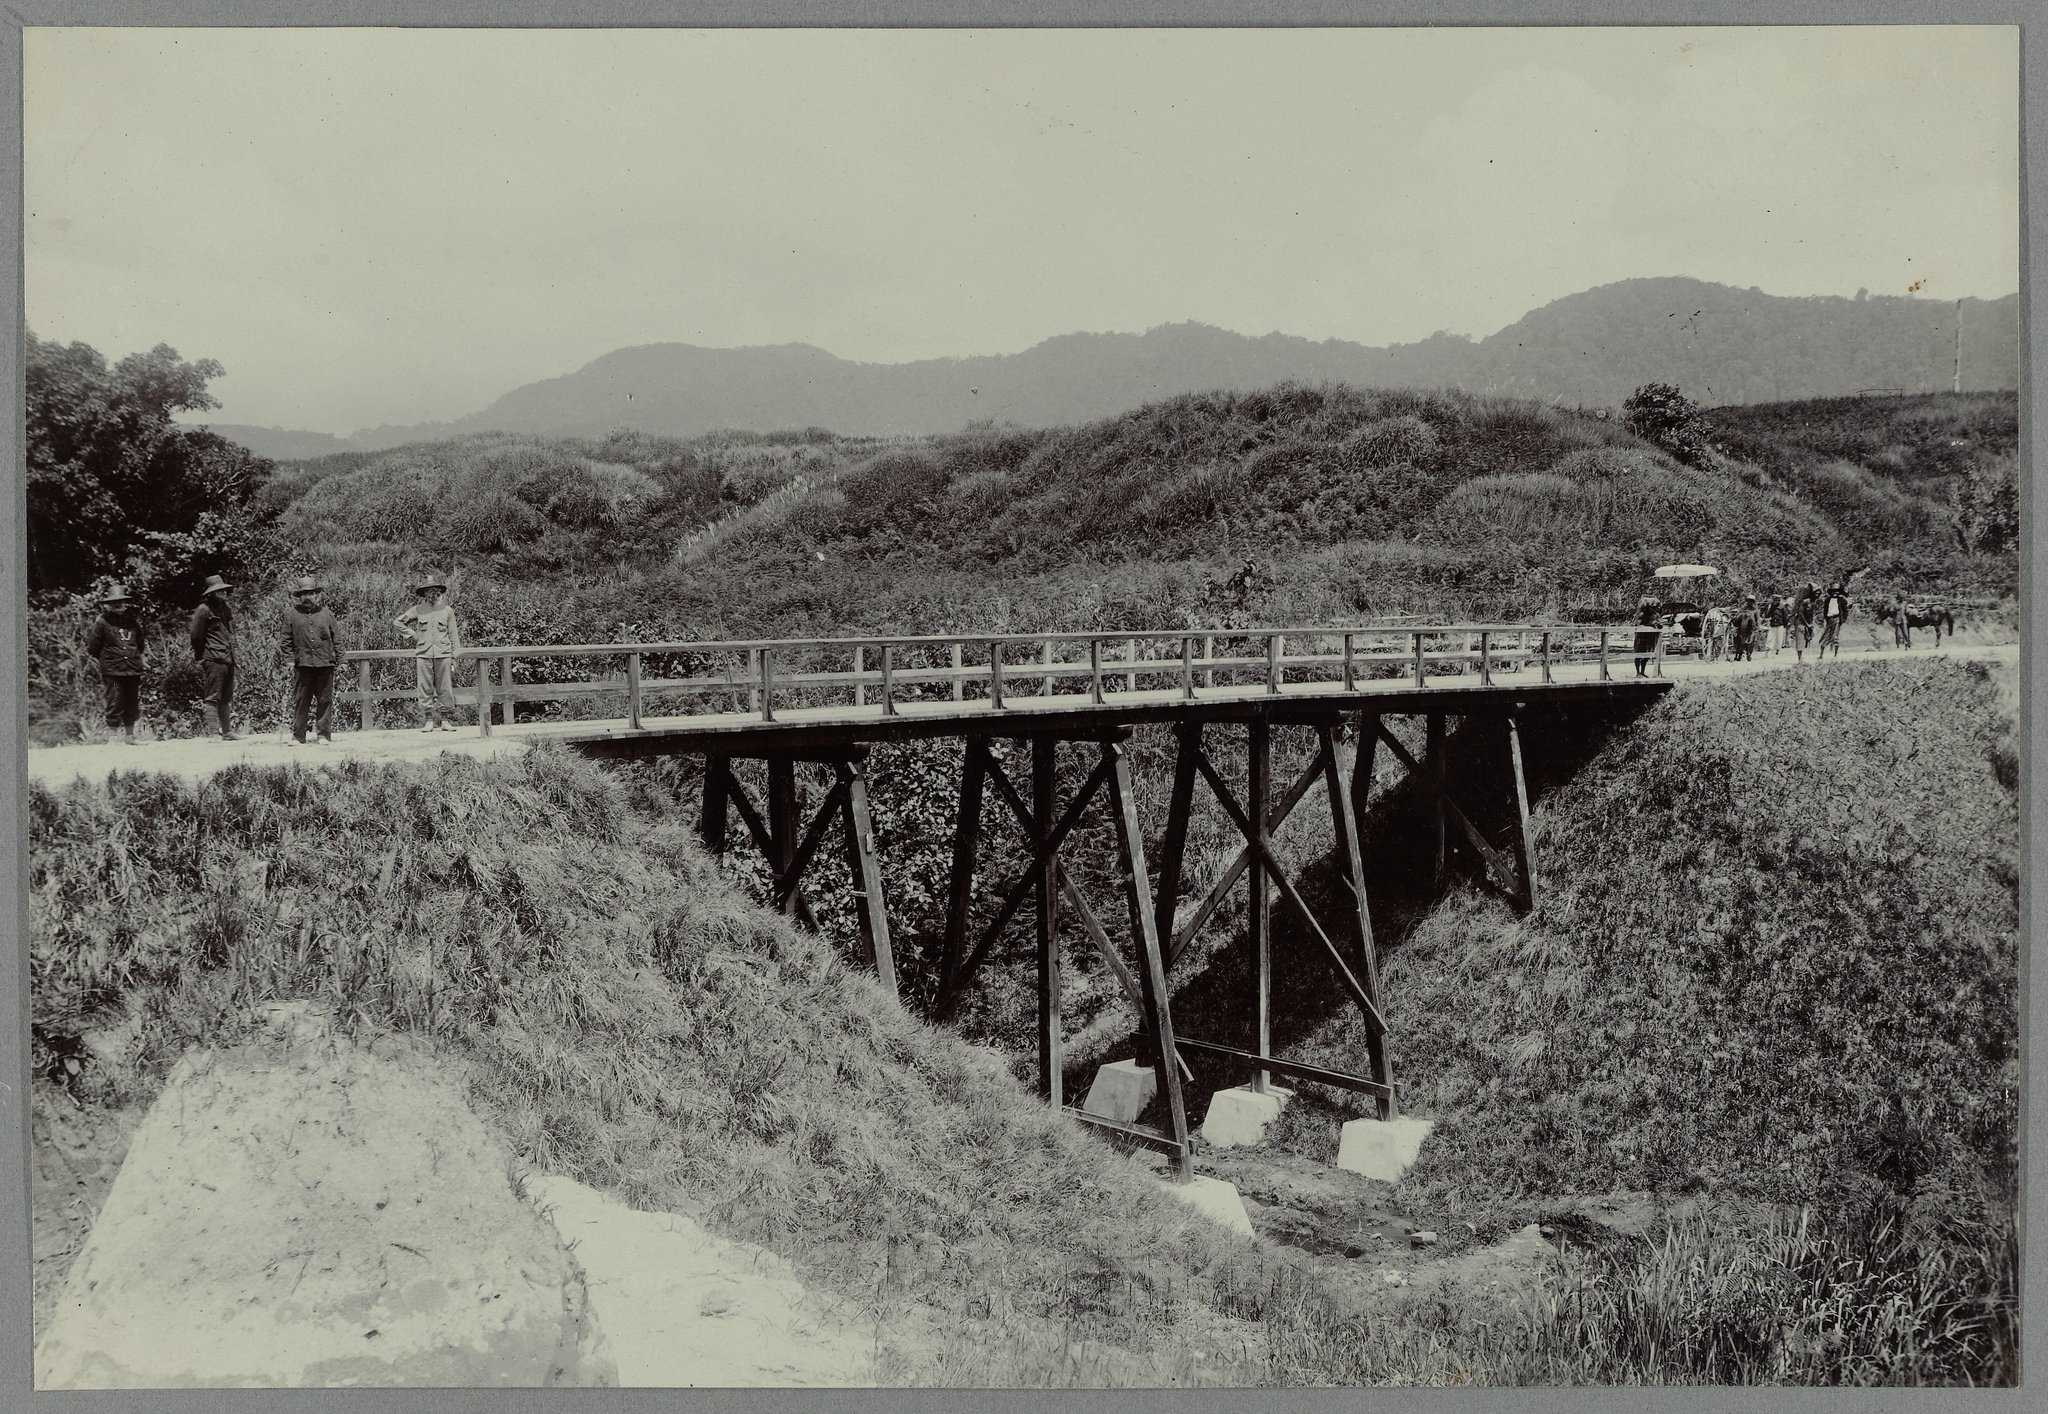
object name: photograph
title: Brug over de Aroel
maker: Anonymous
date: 1903-1913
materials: photographic support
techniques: photography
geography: north sumatra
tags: albertus dominicus laman trip, landscapes in tropical and sub-tropical regions, bridge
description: Na de expedities naar de Gajo- en Alaslanden o.l.v. Van Daalen (eerste tocht in 1901), werd hij in 1903 belast met voorbereiding van permanente vestiging van Nederlands gezag. Aanleg van een weg van de Noordkust naar het binnenland was hierbij van groot belang. Deze zgn. Gajoweg werd aangelegd tussen 1903 en 1914, van Bireuen aan de kust naar Takinguen aan het bergmeer Danau Lauttawar, totale lente 104 km.